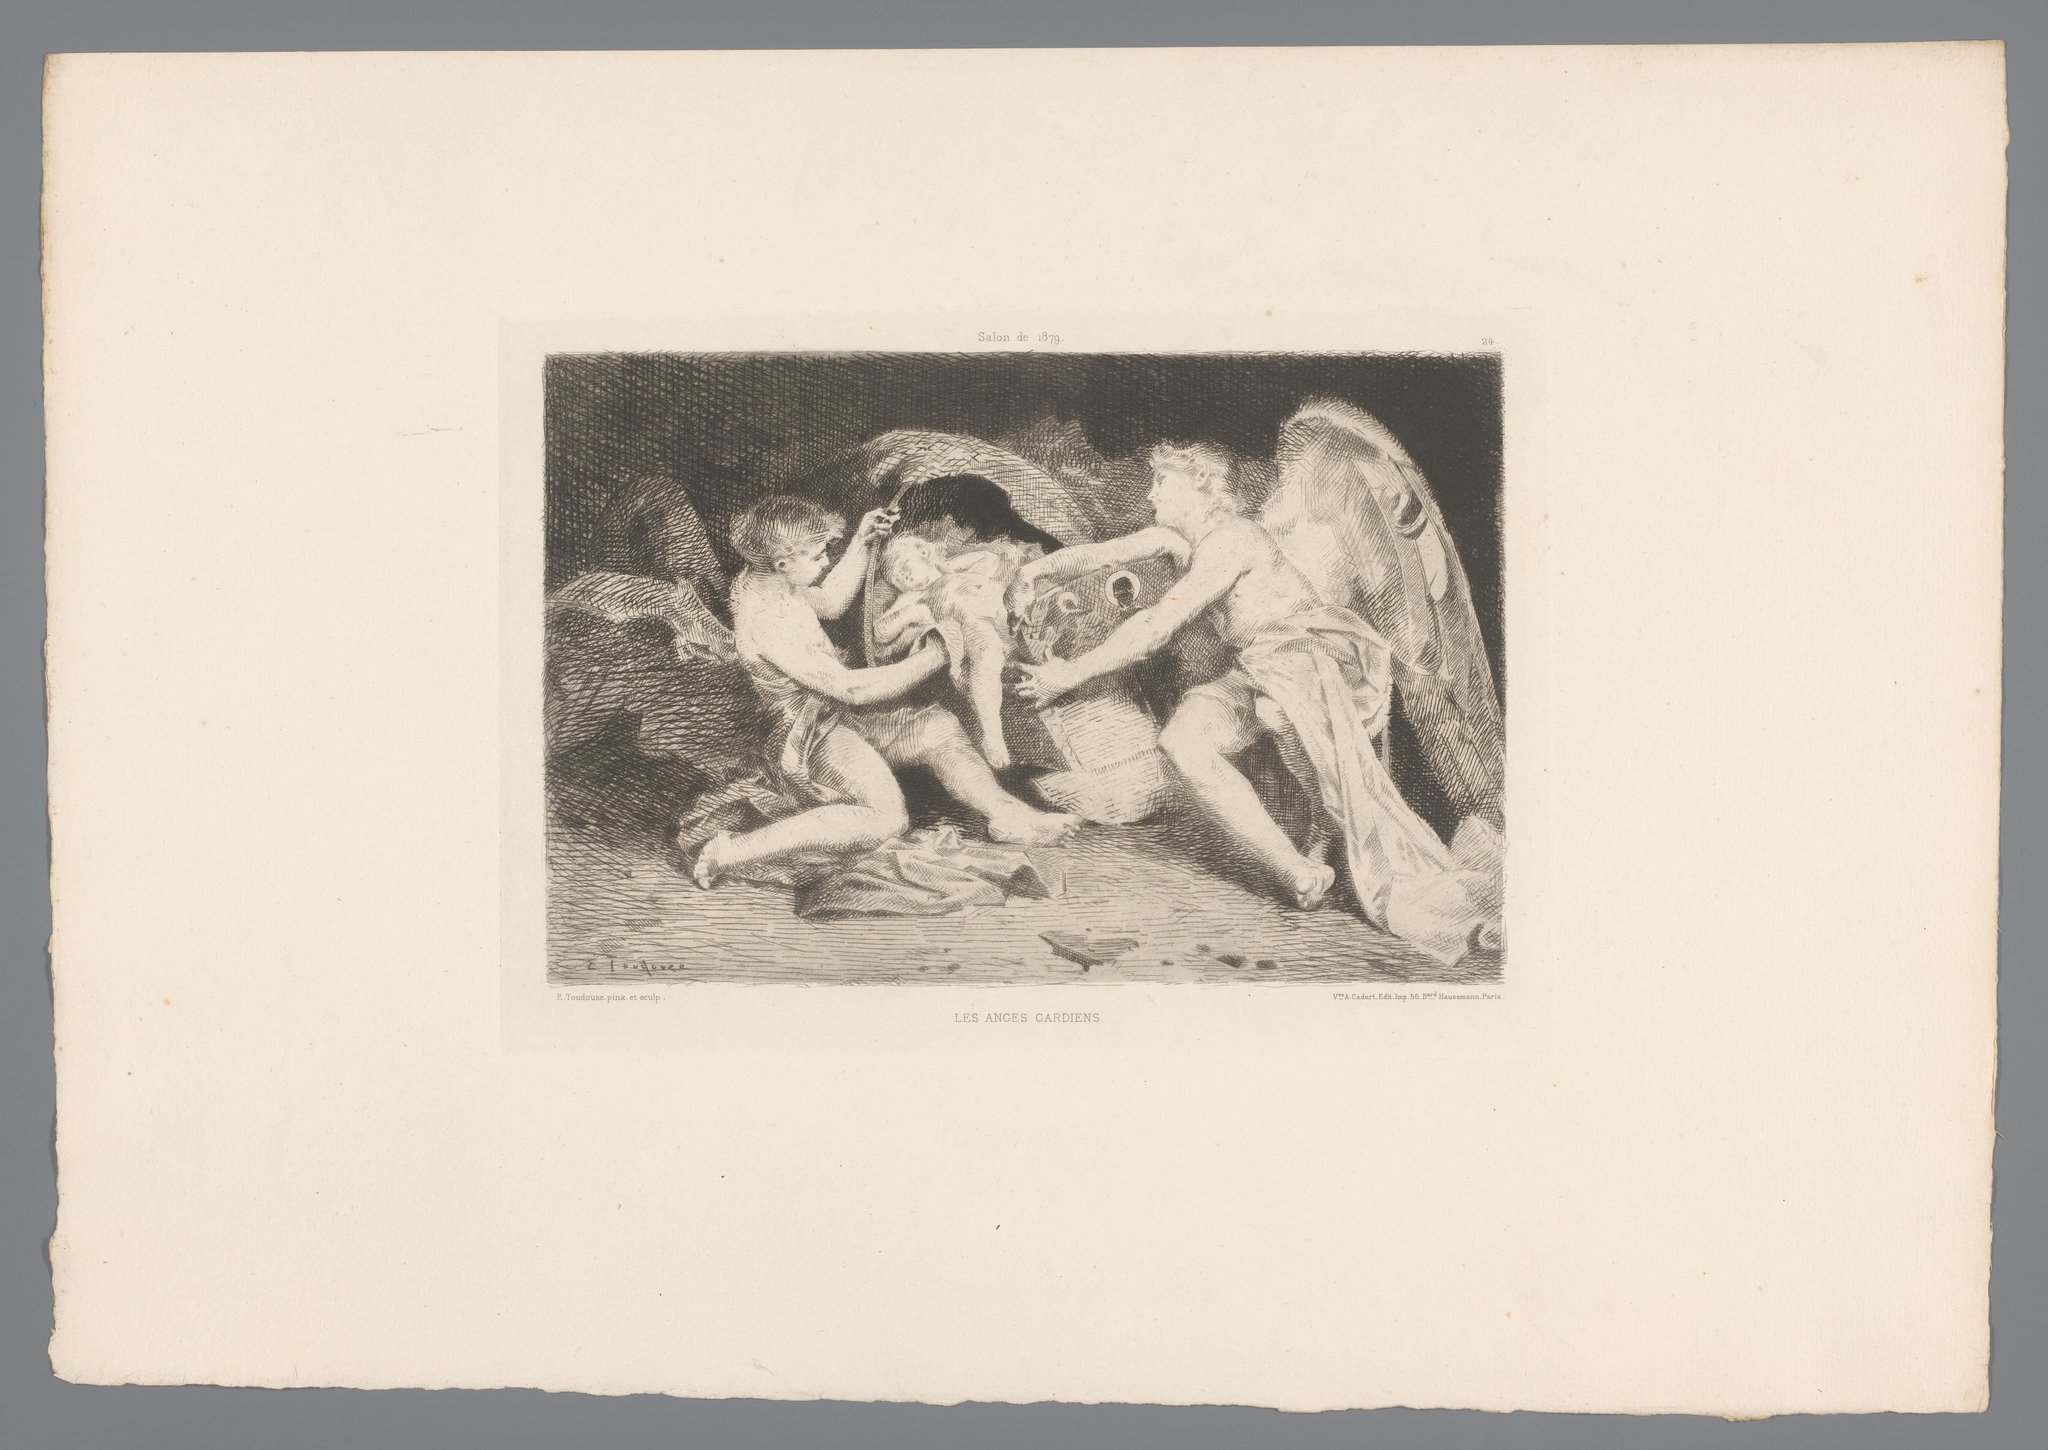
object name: print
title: Franse etsen uit 1880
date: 1880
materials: paper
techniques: drypoint, etching, intaglio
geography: paris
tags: guardian angel, sleeping in bed, watching a sleeping child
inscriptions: collector's mark: Lugt 2760, watermark, collector's mark: Lugt 2228, collector's mark: ‘AFE v S’